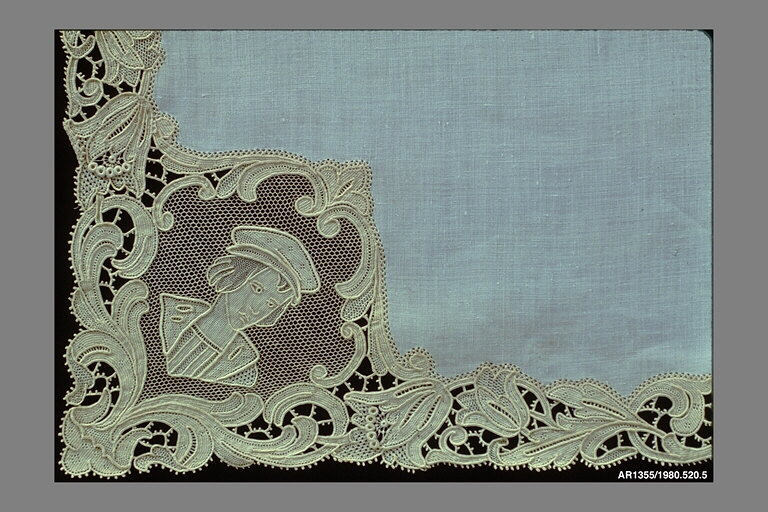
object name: napkin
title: Napkin (from a set of table linens)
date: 1867-1900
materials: linen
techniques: lace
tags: portraits